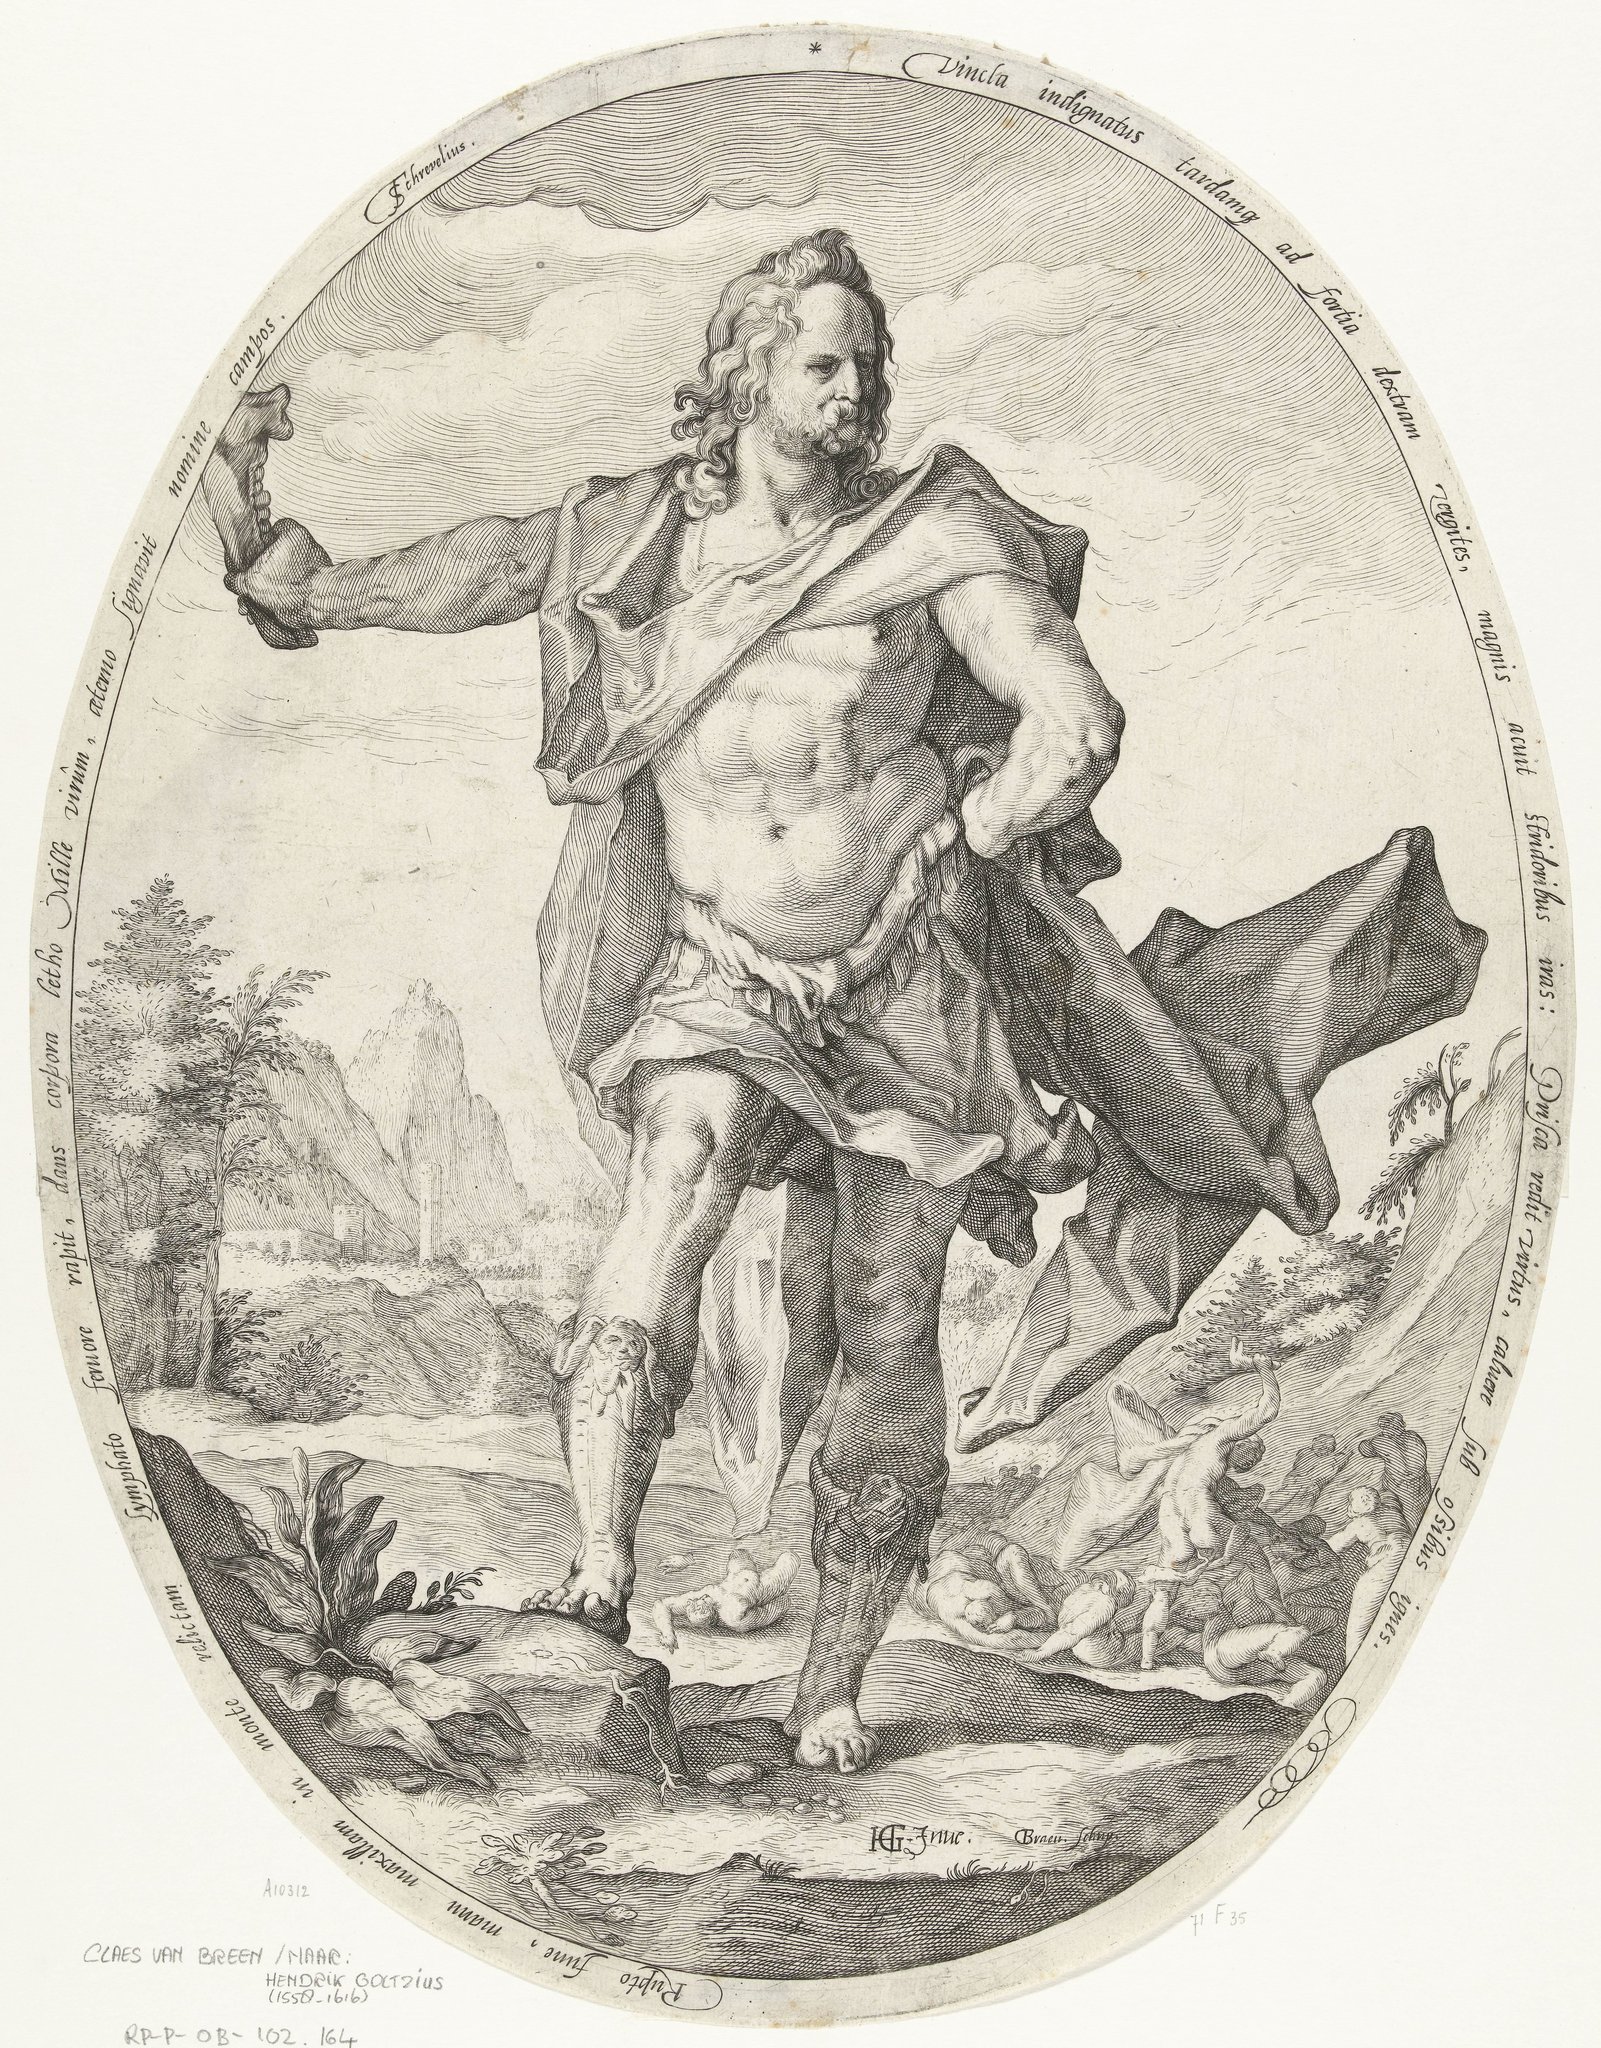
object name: print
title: Simson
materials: paper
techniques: engraving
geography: haarlem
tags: with an ass's jaw-bone samson slays a thousand philistines, samson (not in biblical context); possible attributes: broken pillar, club, jawbone, lion's head, lion's pelt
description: Simson met het kaakbeen van een ezel in zijn hand, de andere hand in zijn zij. Op de achtergrond is te zien hoe Simson met het kaakbeen de Filistijnen verslaat omdat ze hem bespot hebben. In ovaal met randschrift in het Latijn door Theodorus Schrevelius.